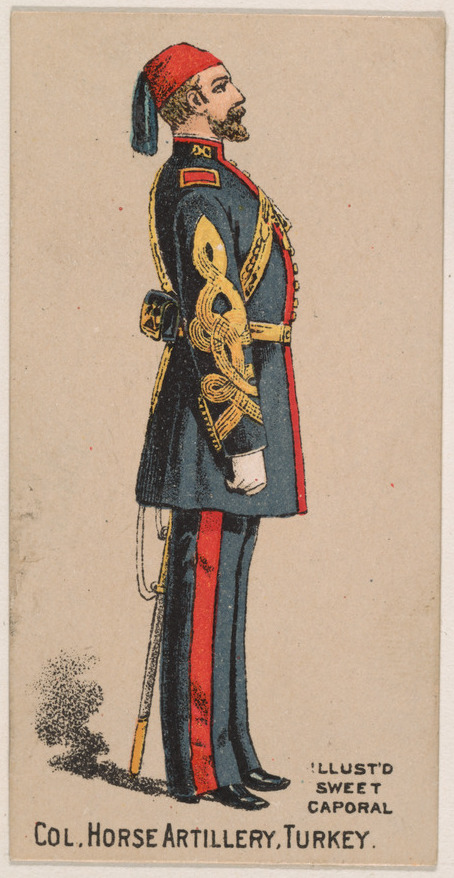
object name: print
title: Colonel, Horse Artillery, Turkey, from the Military Series (N224) issued by Kinney Tobacco Company to promote Sweet Caporal Cigarettes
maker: kinney brothers tobacco company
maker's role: publisher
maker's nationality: american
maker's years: 1869-2011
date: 1888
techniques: color lithograph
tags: soldiers,swords,men,profiles